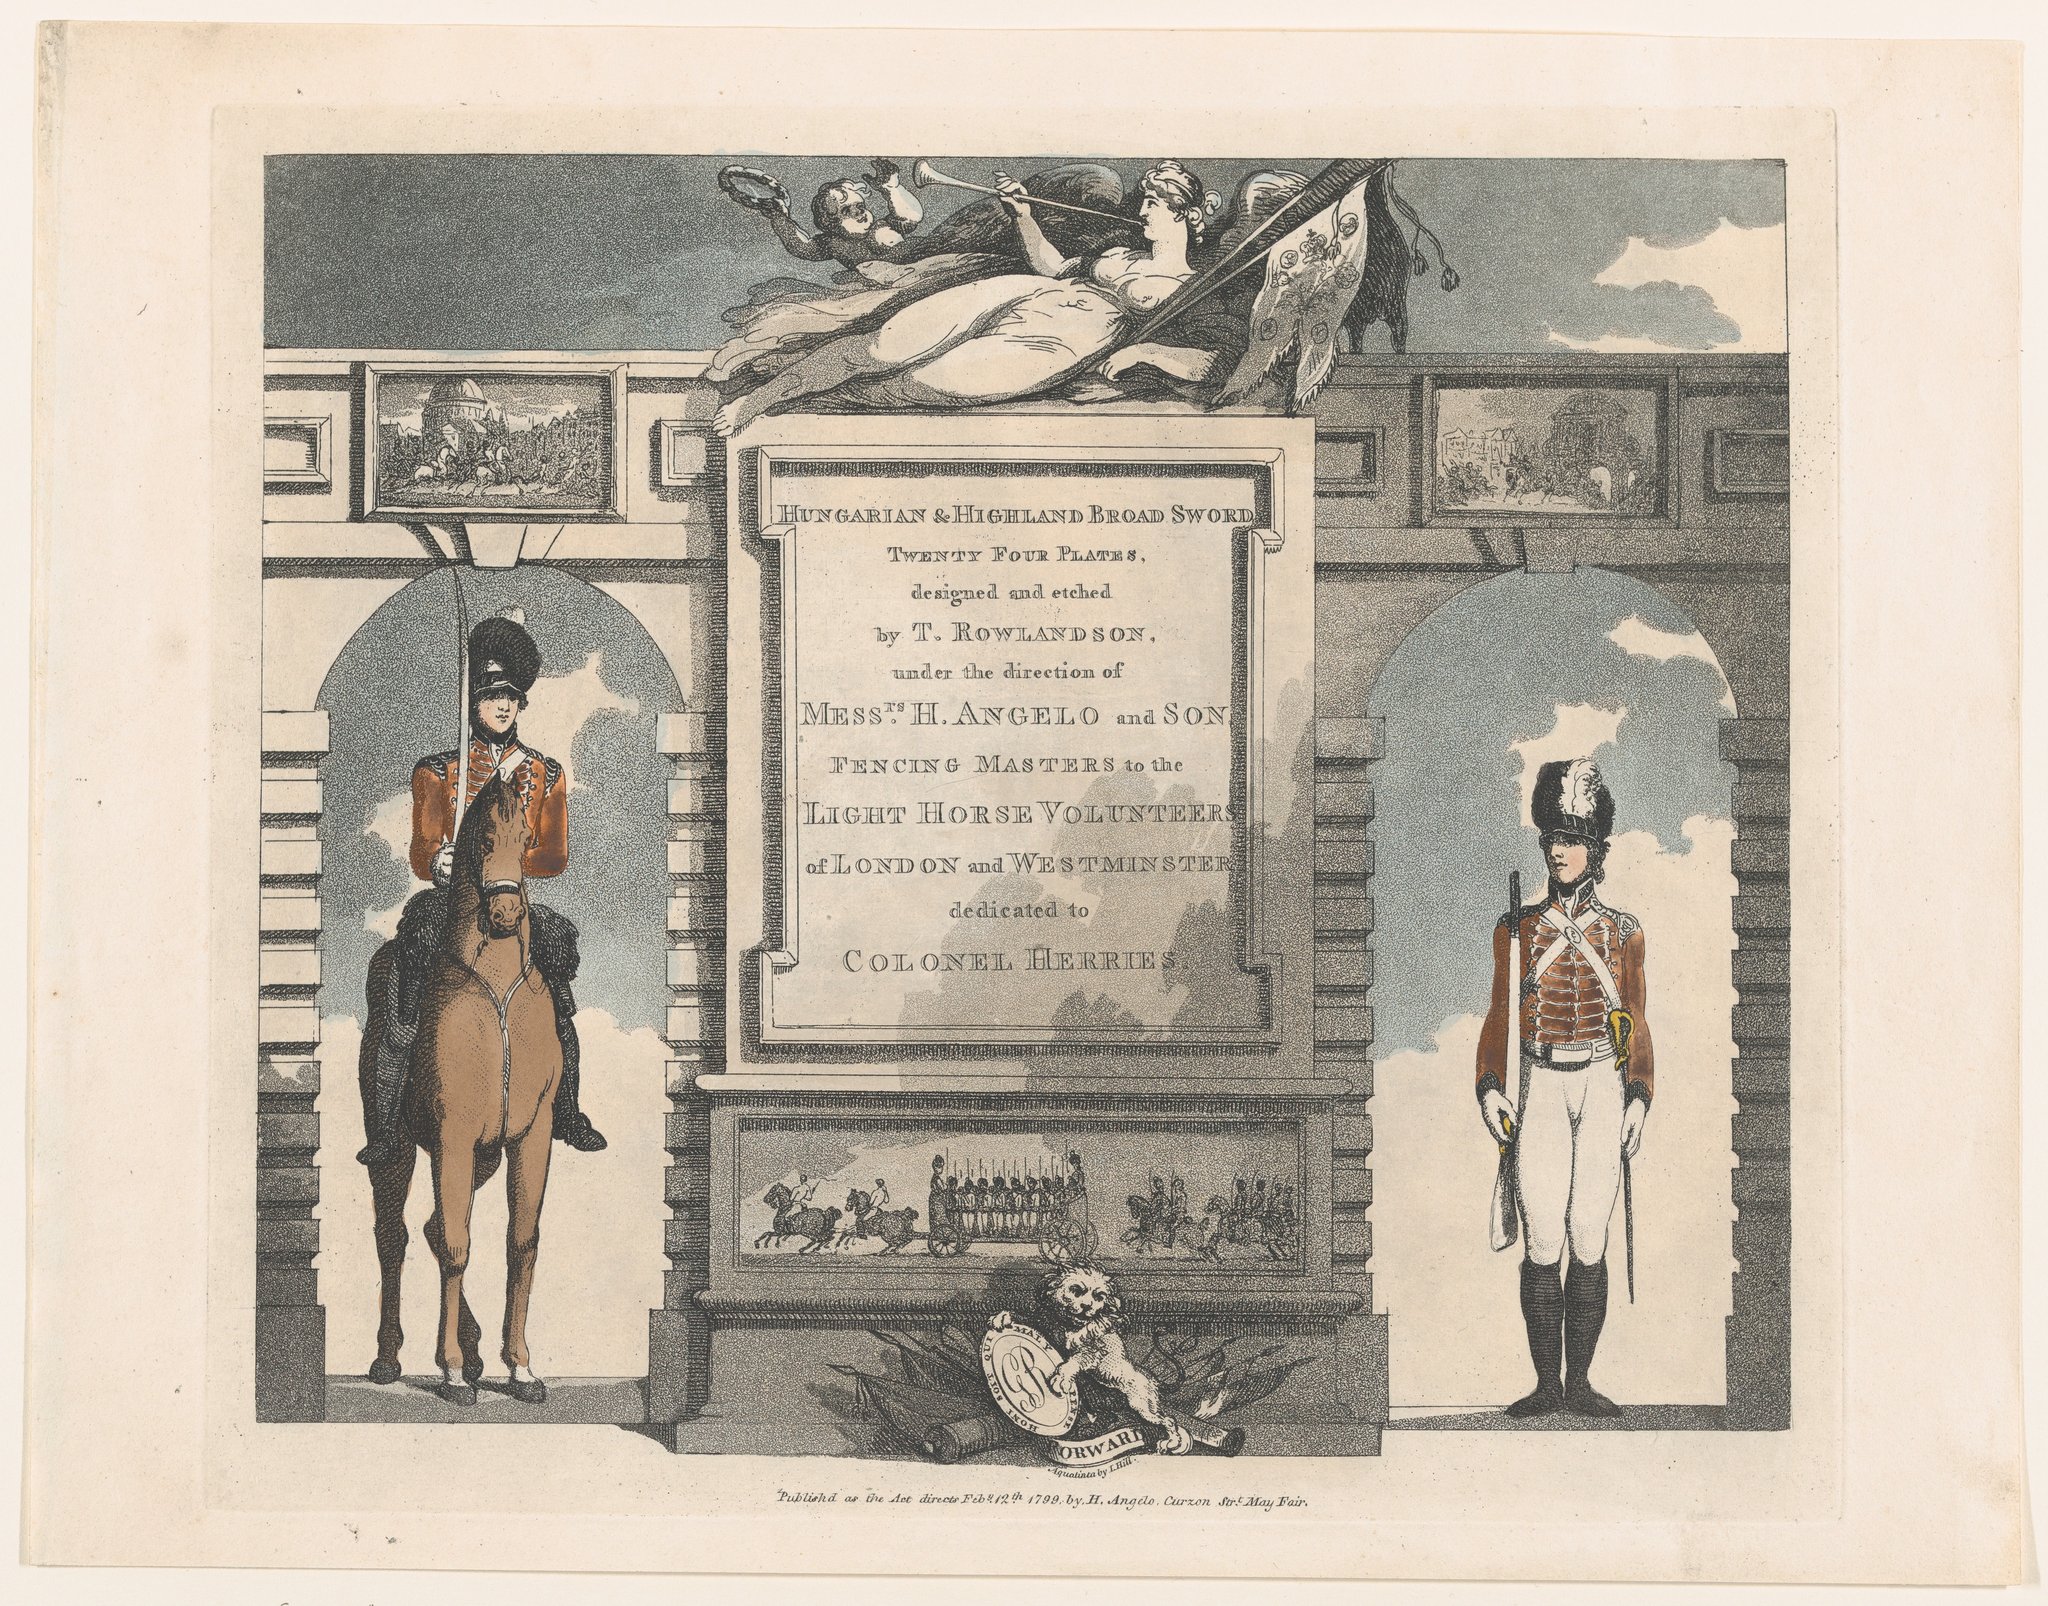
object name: print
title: Forward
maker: thomas rowlandson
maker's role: artist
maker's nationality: british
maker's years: 1757-1827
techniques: aquatint, etching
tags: military,men,horses